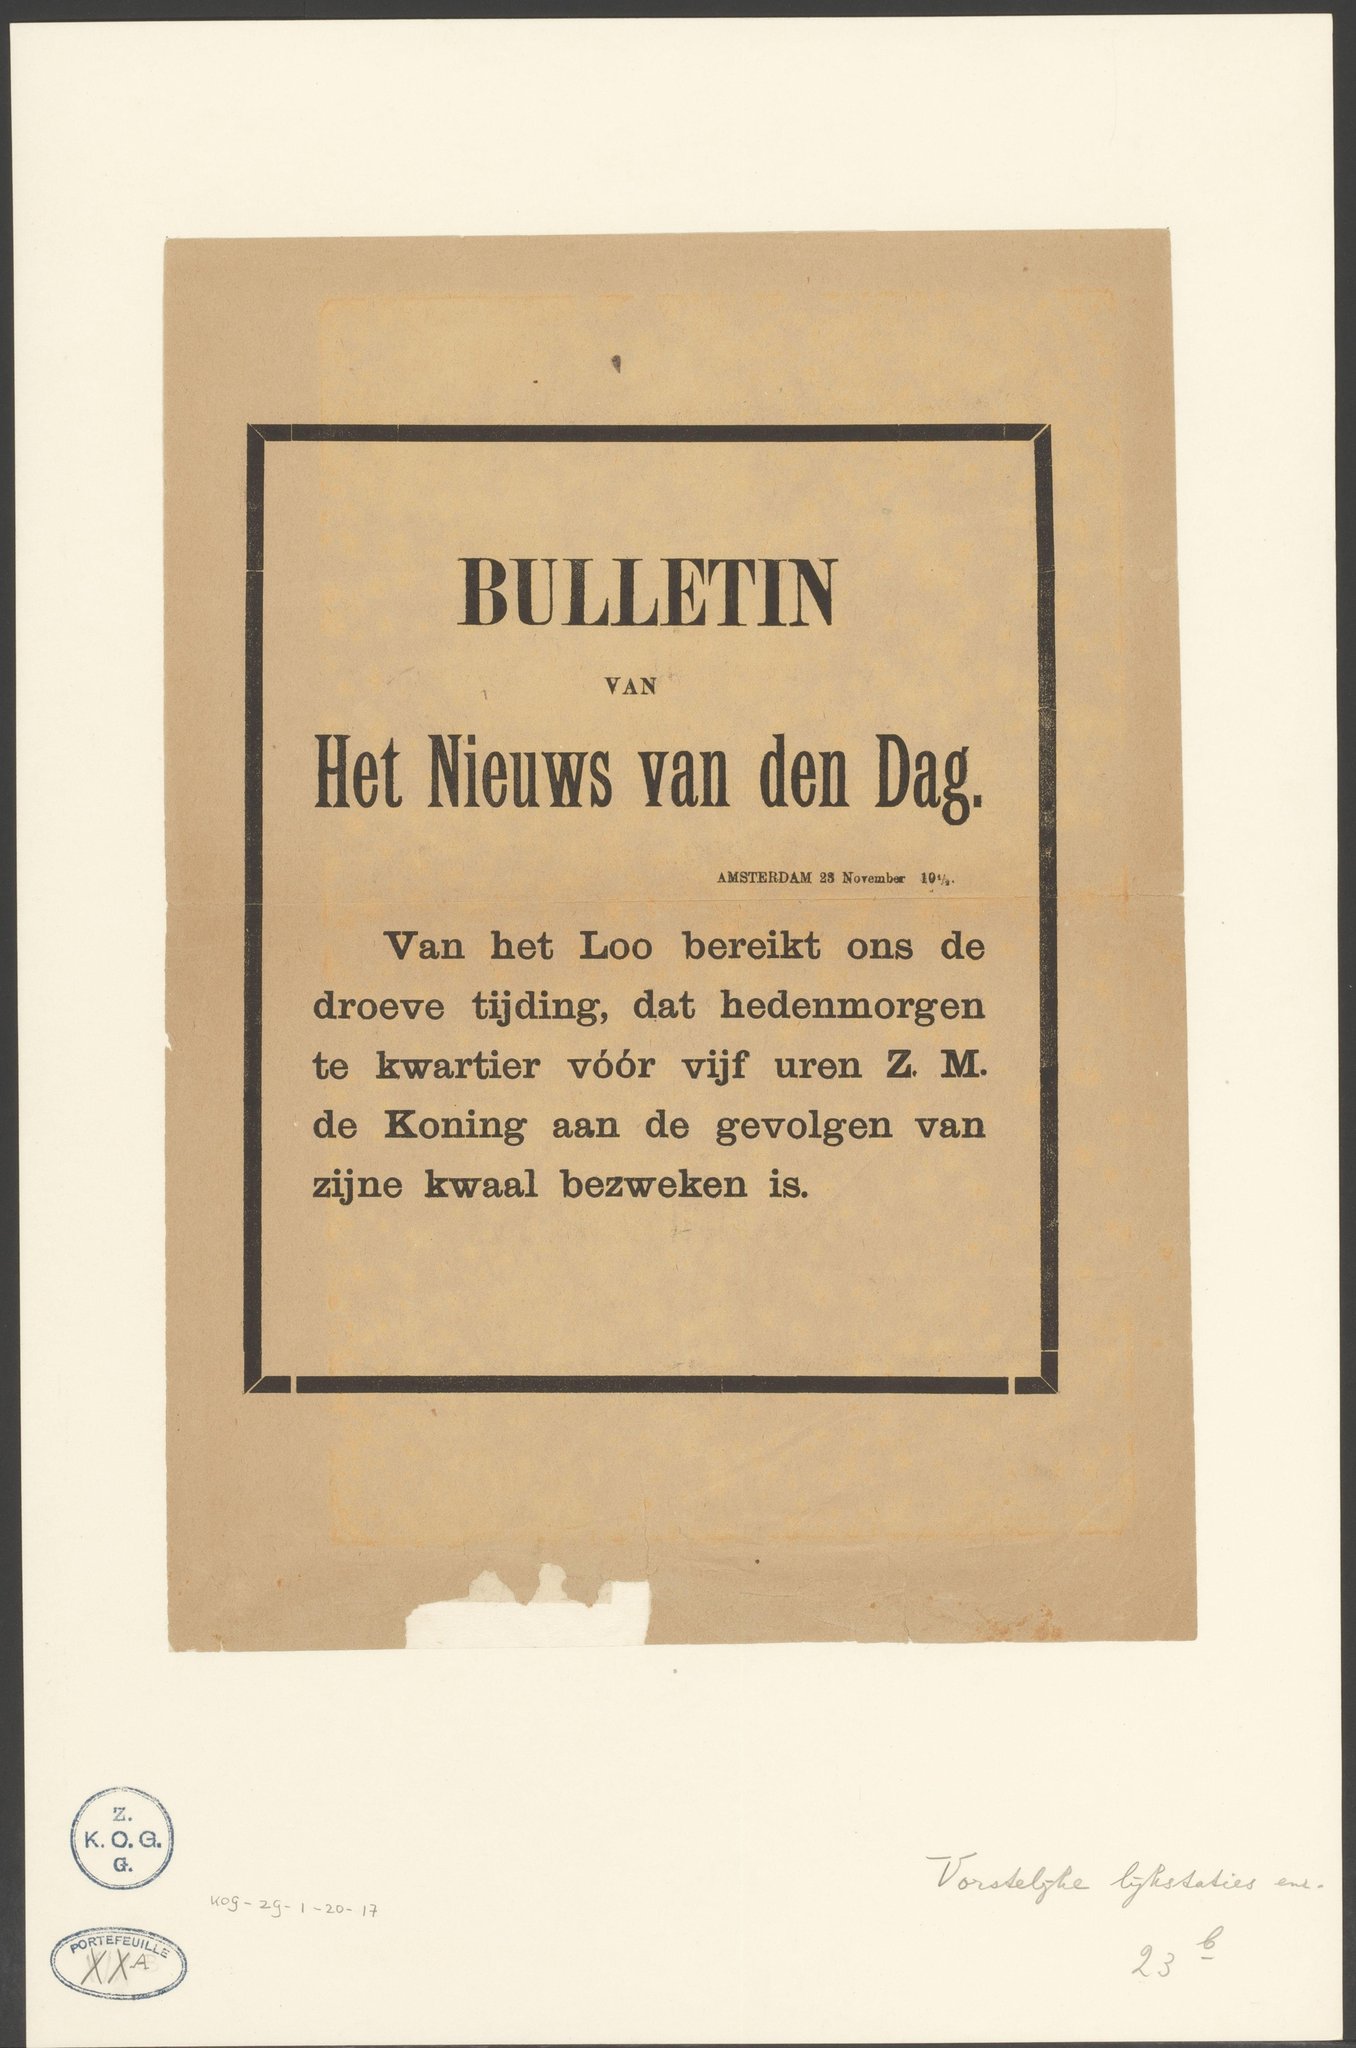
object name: text sheet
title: Bulletin van Het Nieuws van den Dag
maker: Anonymous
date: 1890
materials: paper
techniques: letterpress printing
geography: amsterdam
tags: brussels, willem iii (koning der nederlanden)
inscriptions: stamp, collector's mark: Lugt 1641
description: Onderwerpsrubrieken binnen de Atlas Zeden en Gewoonten: Zeden en Gewoonten in Engeren Zin, Des menschen beging, midden en einde, Vorstelijke lijkstaties.